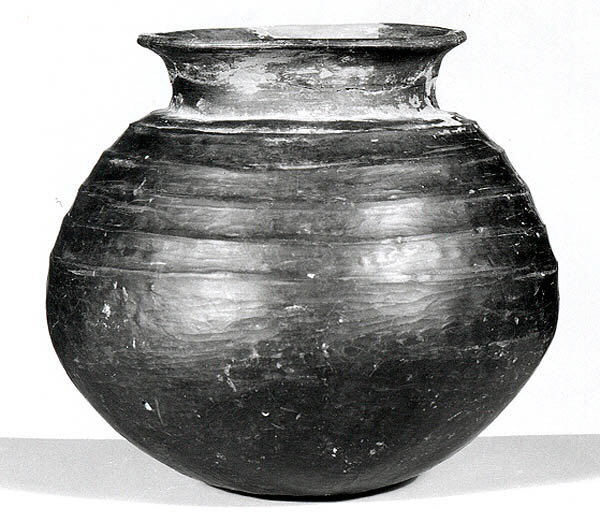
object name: jar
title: Jar with ribbed decoration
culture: iranian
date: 2800 BCE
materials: ceramic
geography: iran